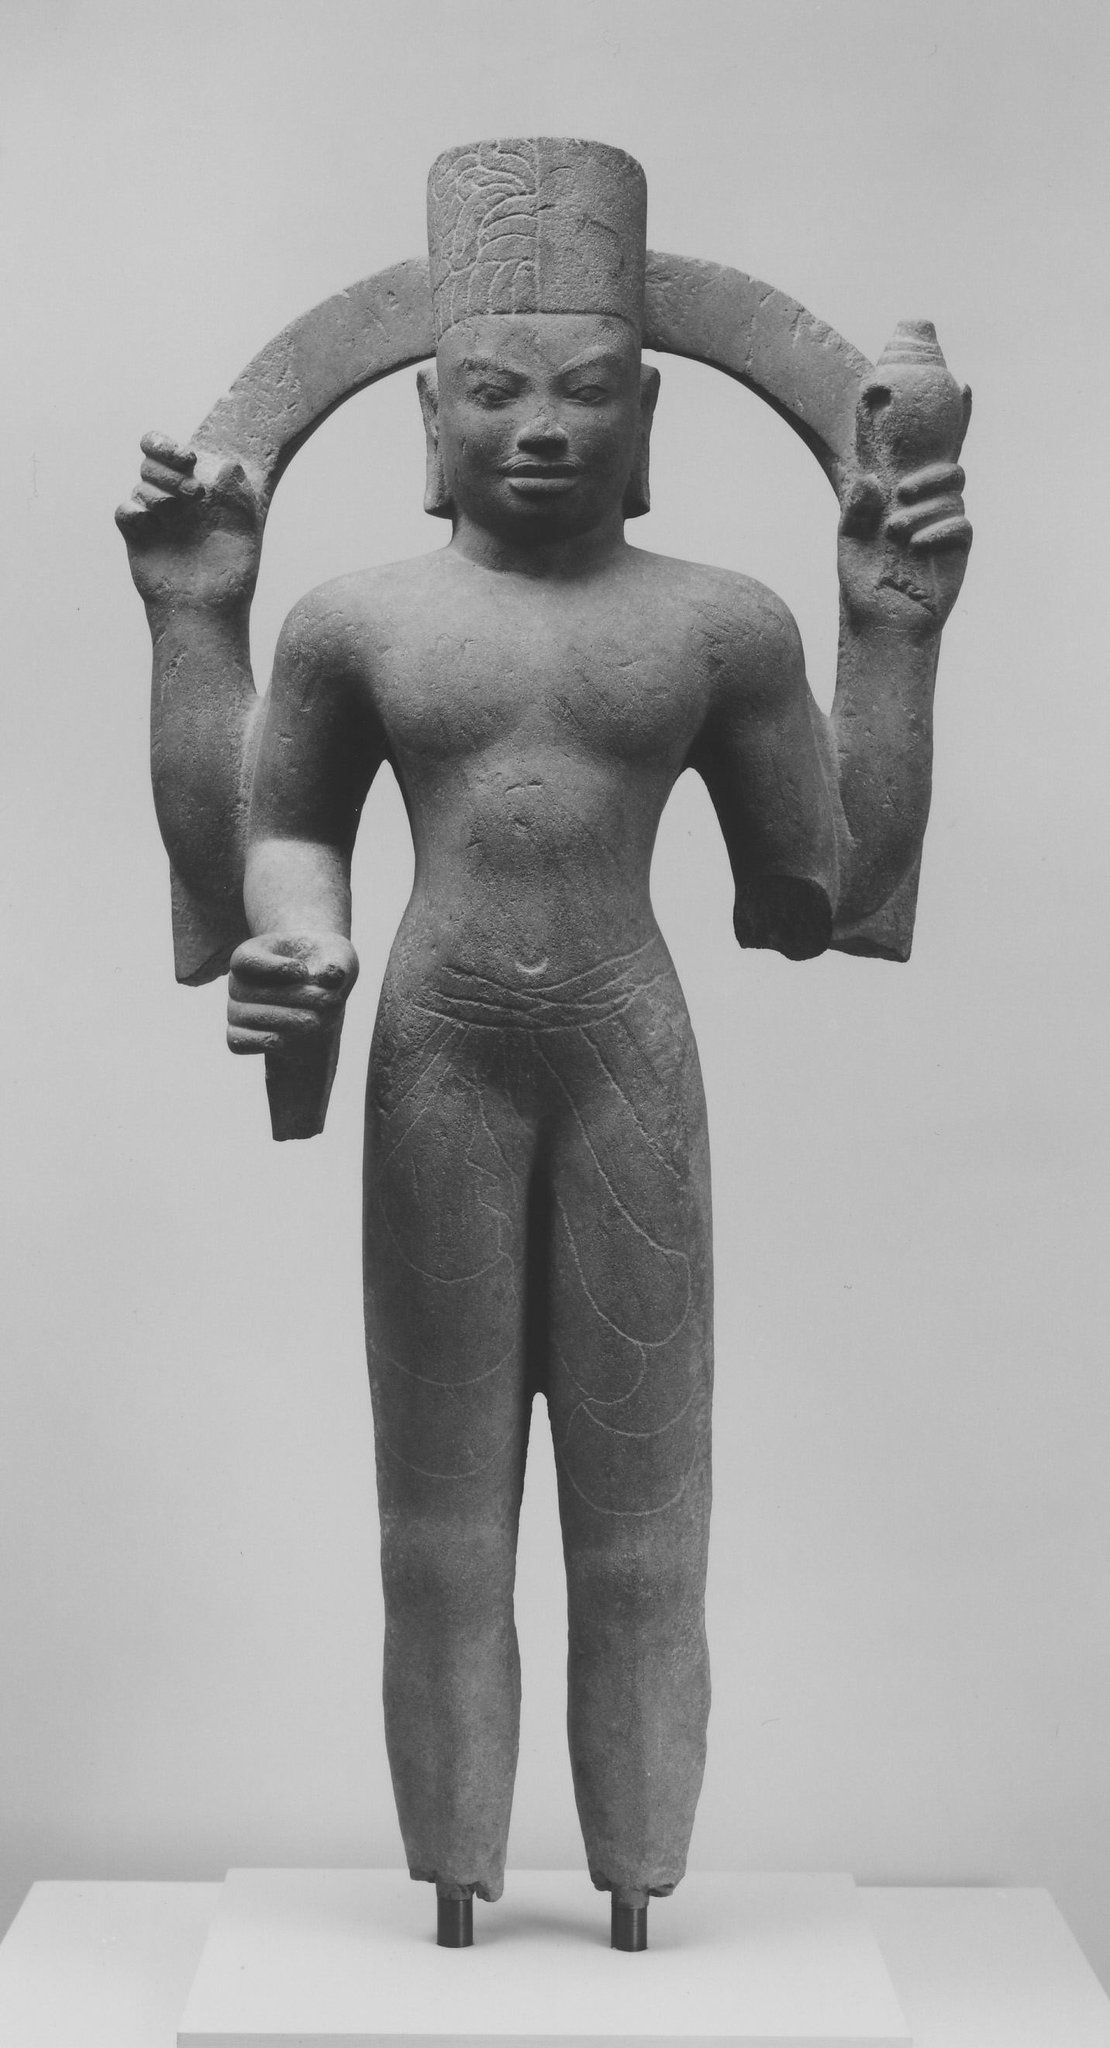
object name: figure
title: Standing Hari-Hara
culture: vietnamese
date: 701-750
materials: stone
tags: shiva,vishnu,hinduism